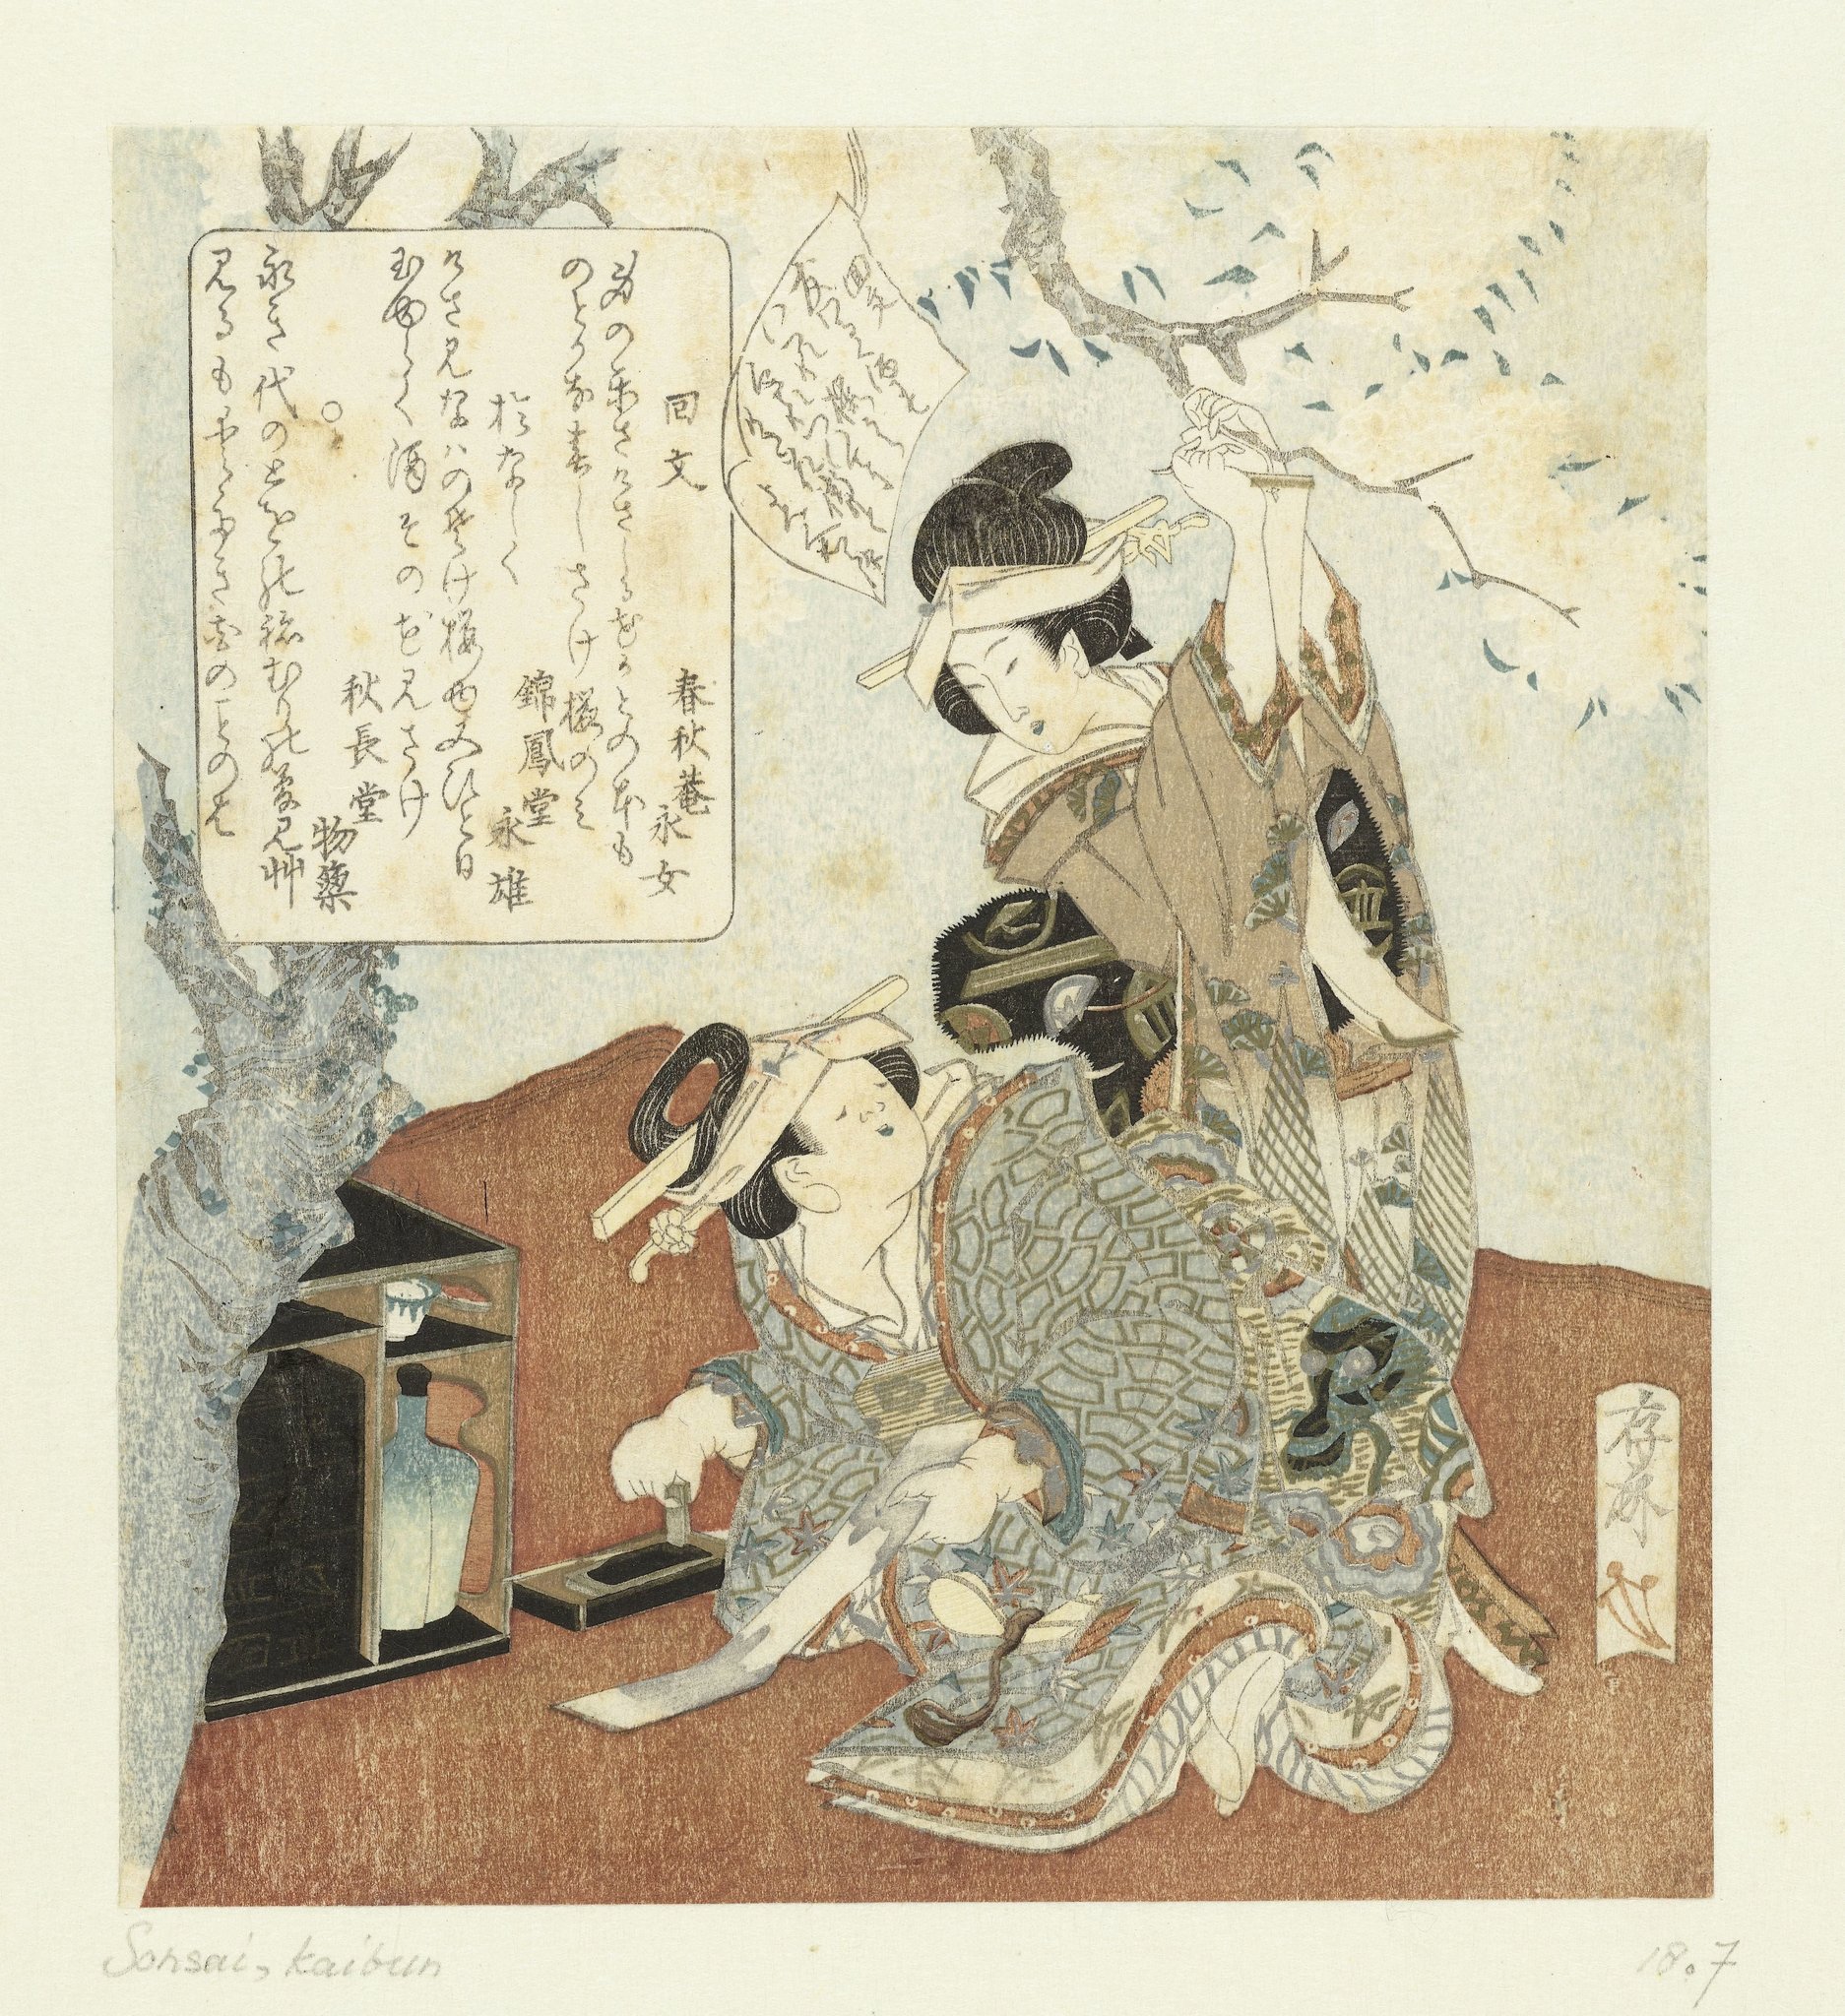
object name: surimono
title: Gedichten ophangen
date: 1832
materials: paper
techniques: blind stamped, woodcut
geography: japan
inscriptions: collector's mark, passe-partout, bottom left, printed: JABdH with a rooster., collector's mark, verso, stamped: Lugt 2228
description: Een surimono is een luxe uitgevoerde prent waarop beeld met één of meerdere gedichten gecombineerd is. Bij het drukken van een surimono werd vaak gebruik gemaakt van dikker papier, blinddruk en metaal pigmenten, zoals koper- en zilverpoeder. De prenten werden vaak in opdracht van dichters gemaakt en als exclusief geschenk aan vrienden en relaties gegeven.